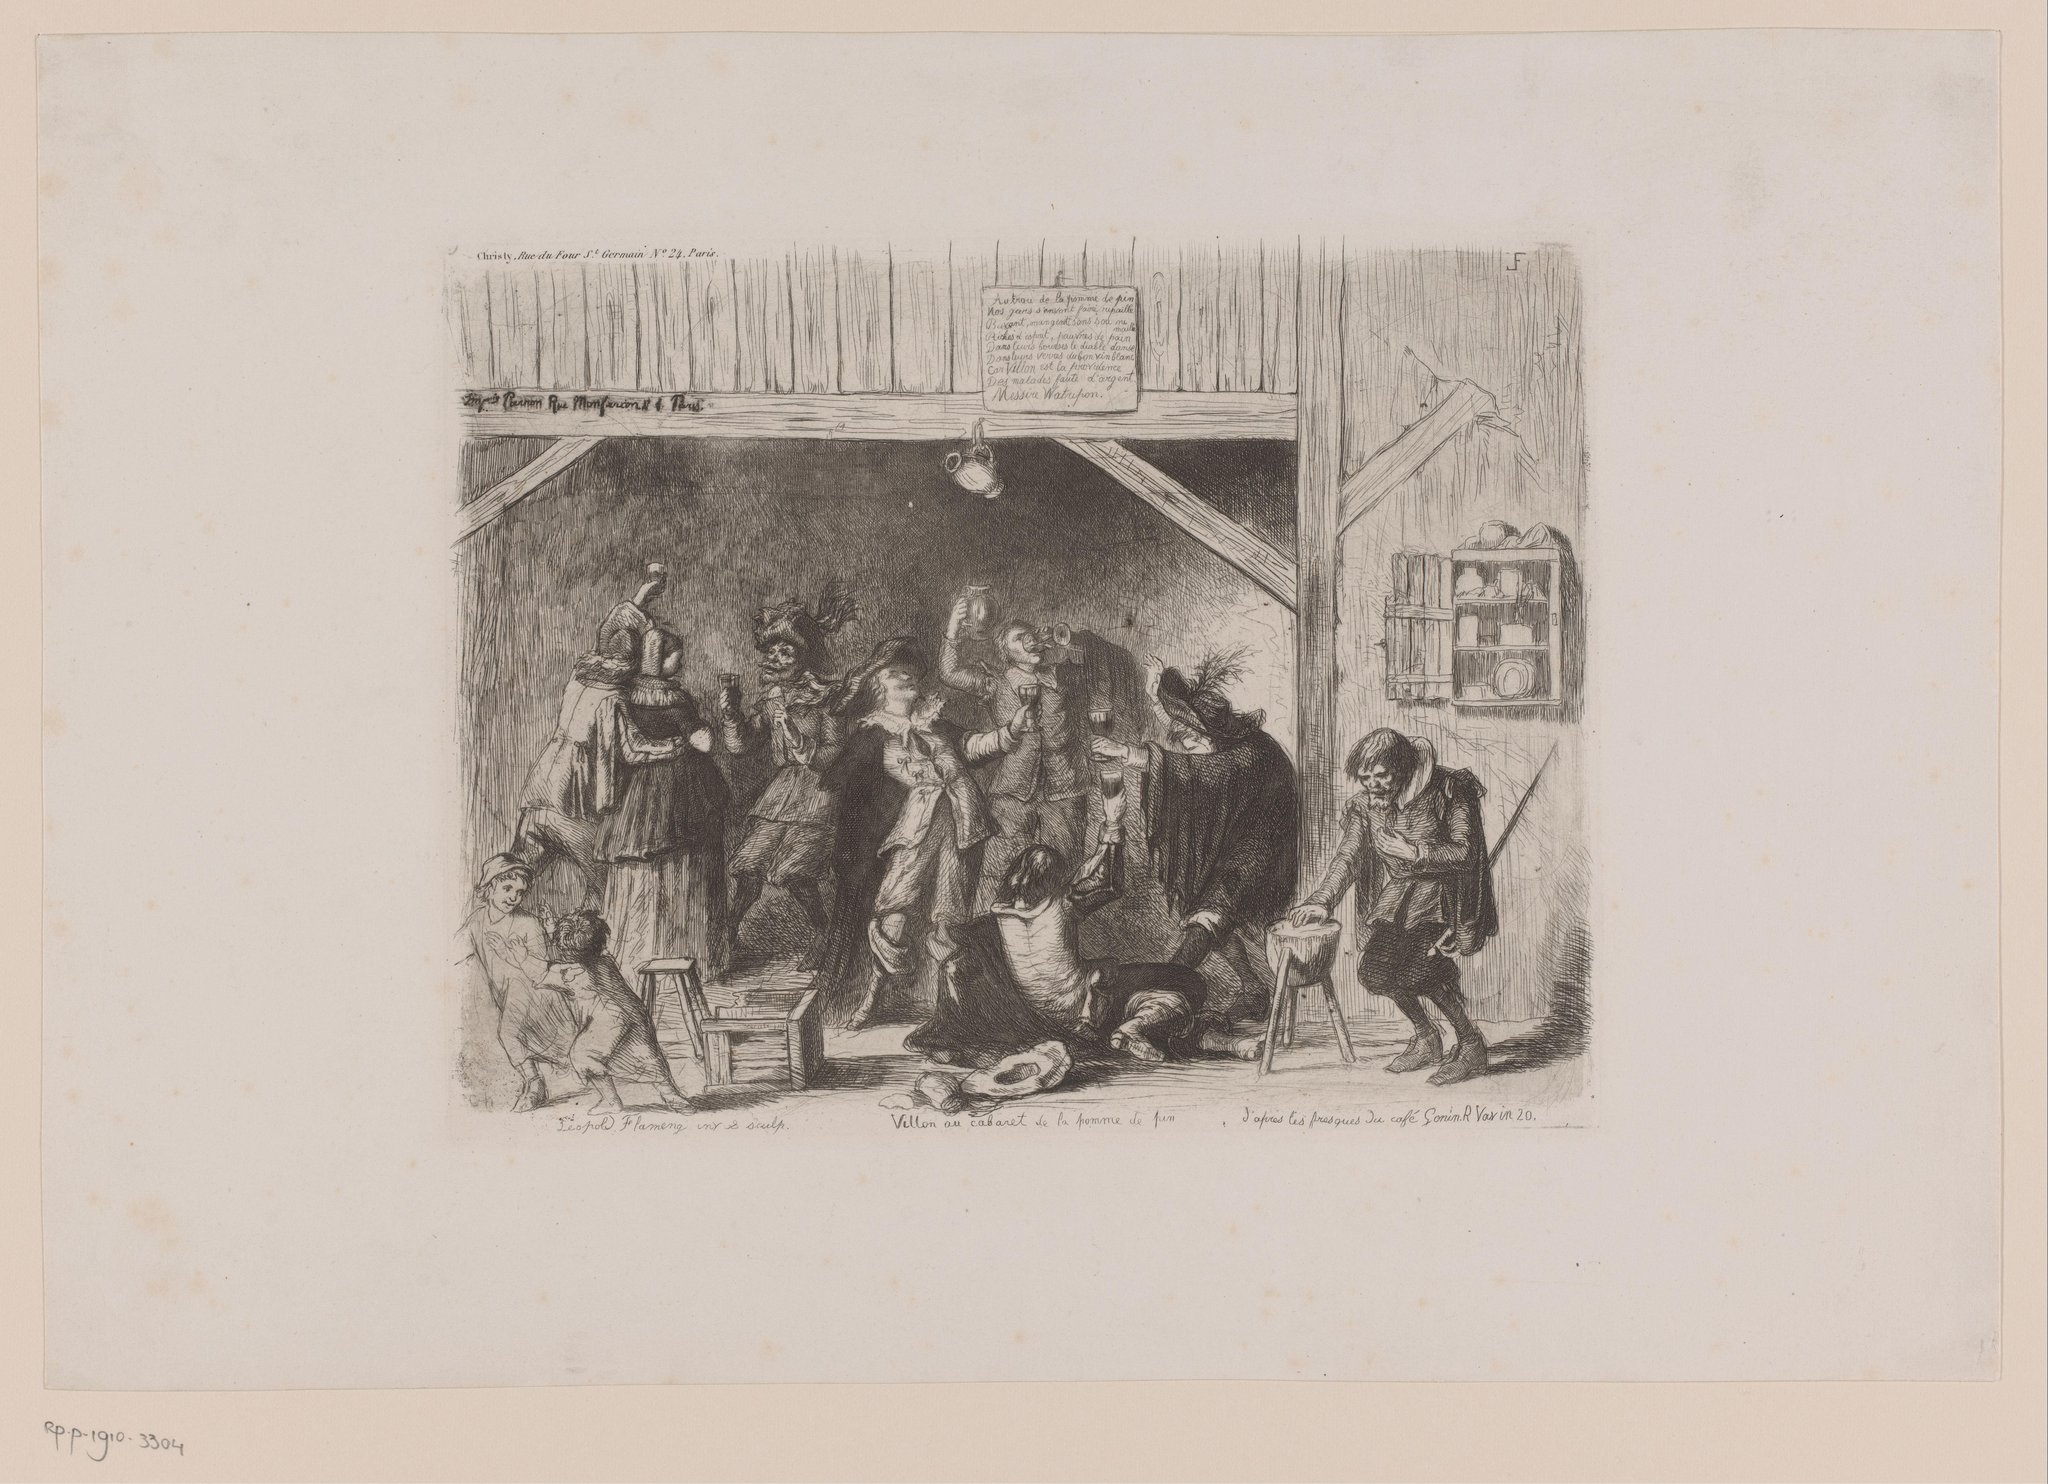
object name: print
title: Villon au cabaret de la Pomme de Pin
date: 1855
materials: paper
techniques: etching, intaglio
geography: paris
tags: inn, coffee-house, public house, etc., drunkenness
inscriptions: annotation: ‘d'apres les fresques du café Gonin. R. Vasin 20.’, collector's mark: Lugt 2228